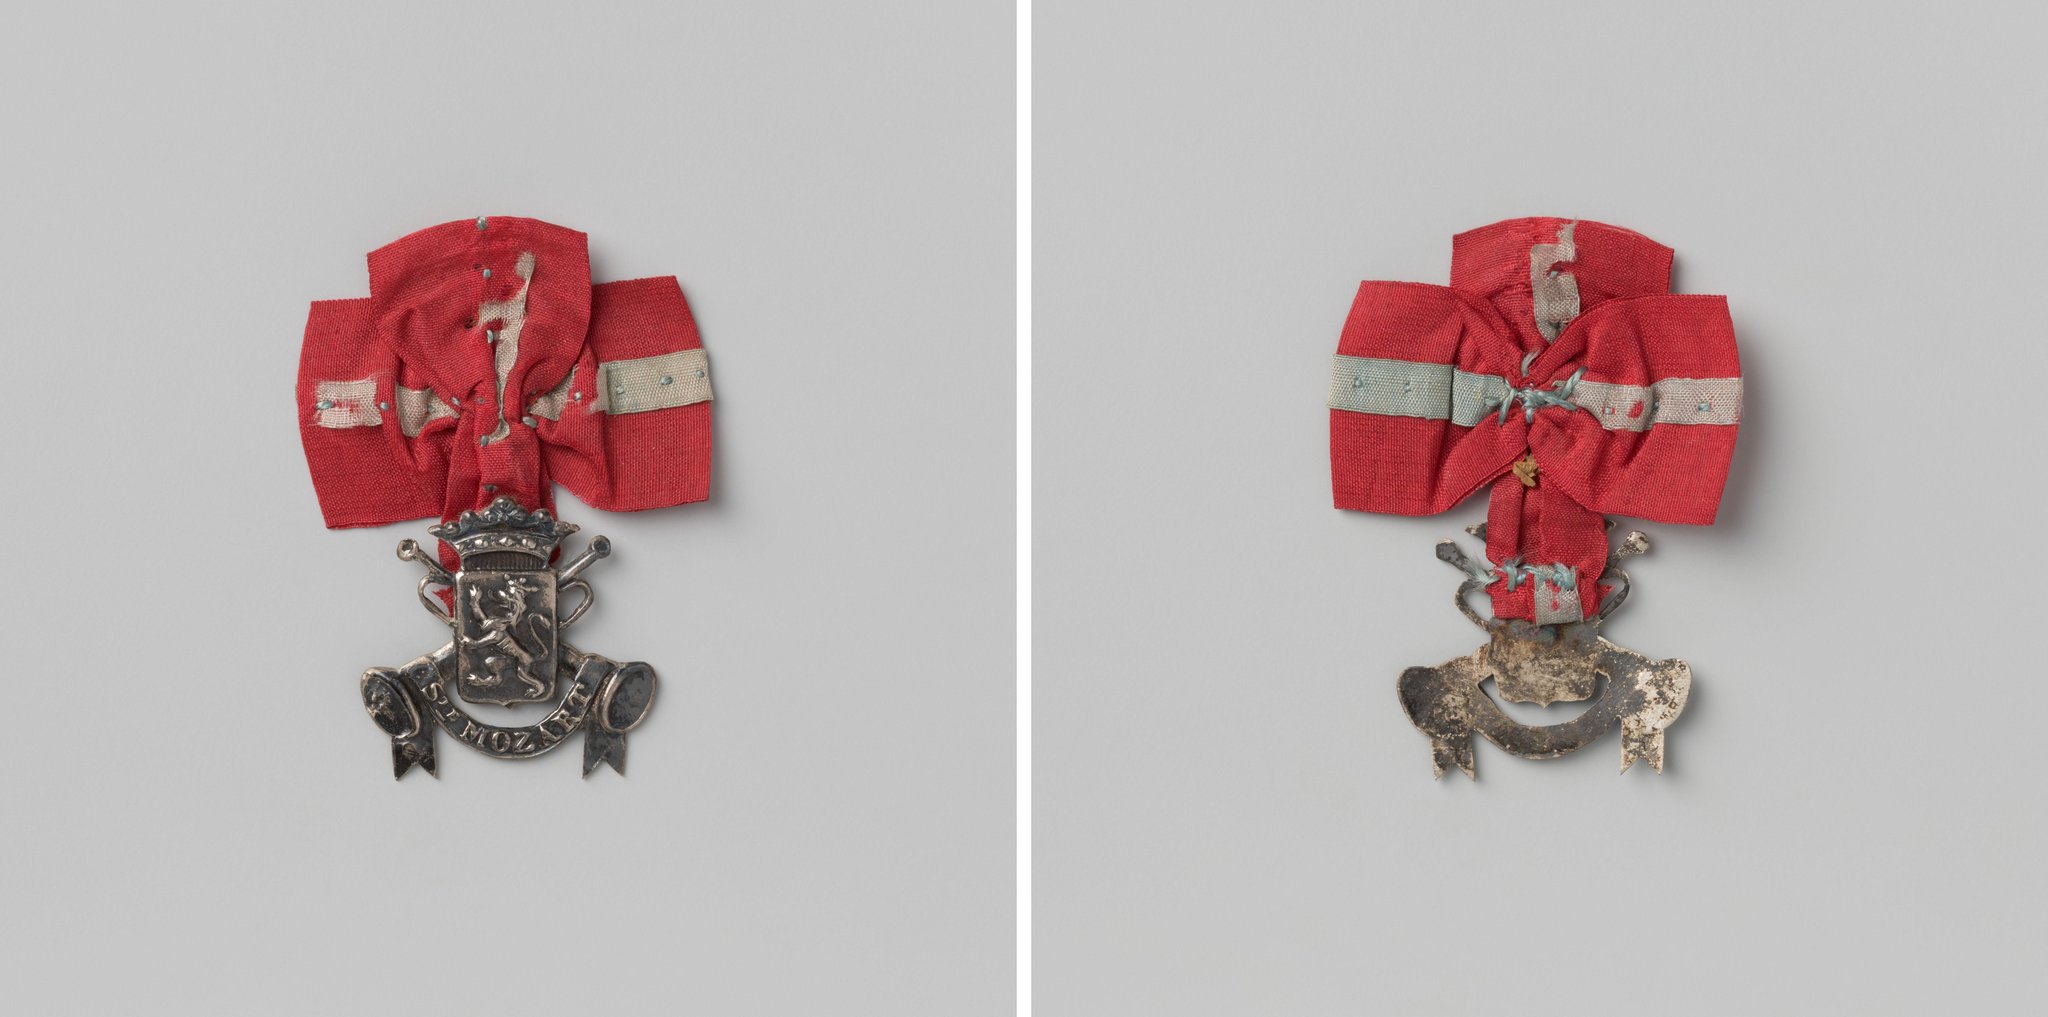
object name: insignia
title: Muziekvereniging Ste Mozart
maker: Anonymous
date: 1825-1875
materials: silver, textile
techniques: striking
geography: amsterdam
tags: amsterdam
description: eenzijdig insigne, bestaand uit gekroond wapenschild op twee gekruiste bazuinen, omhangen met wimpel met opschrift; aan keerzijde bevestigd een strik met witte baan tussen twee roze